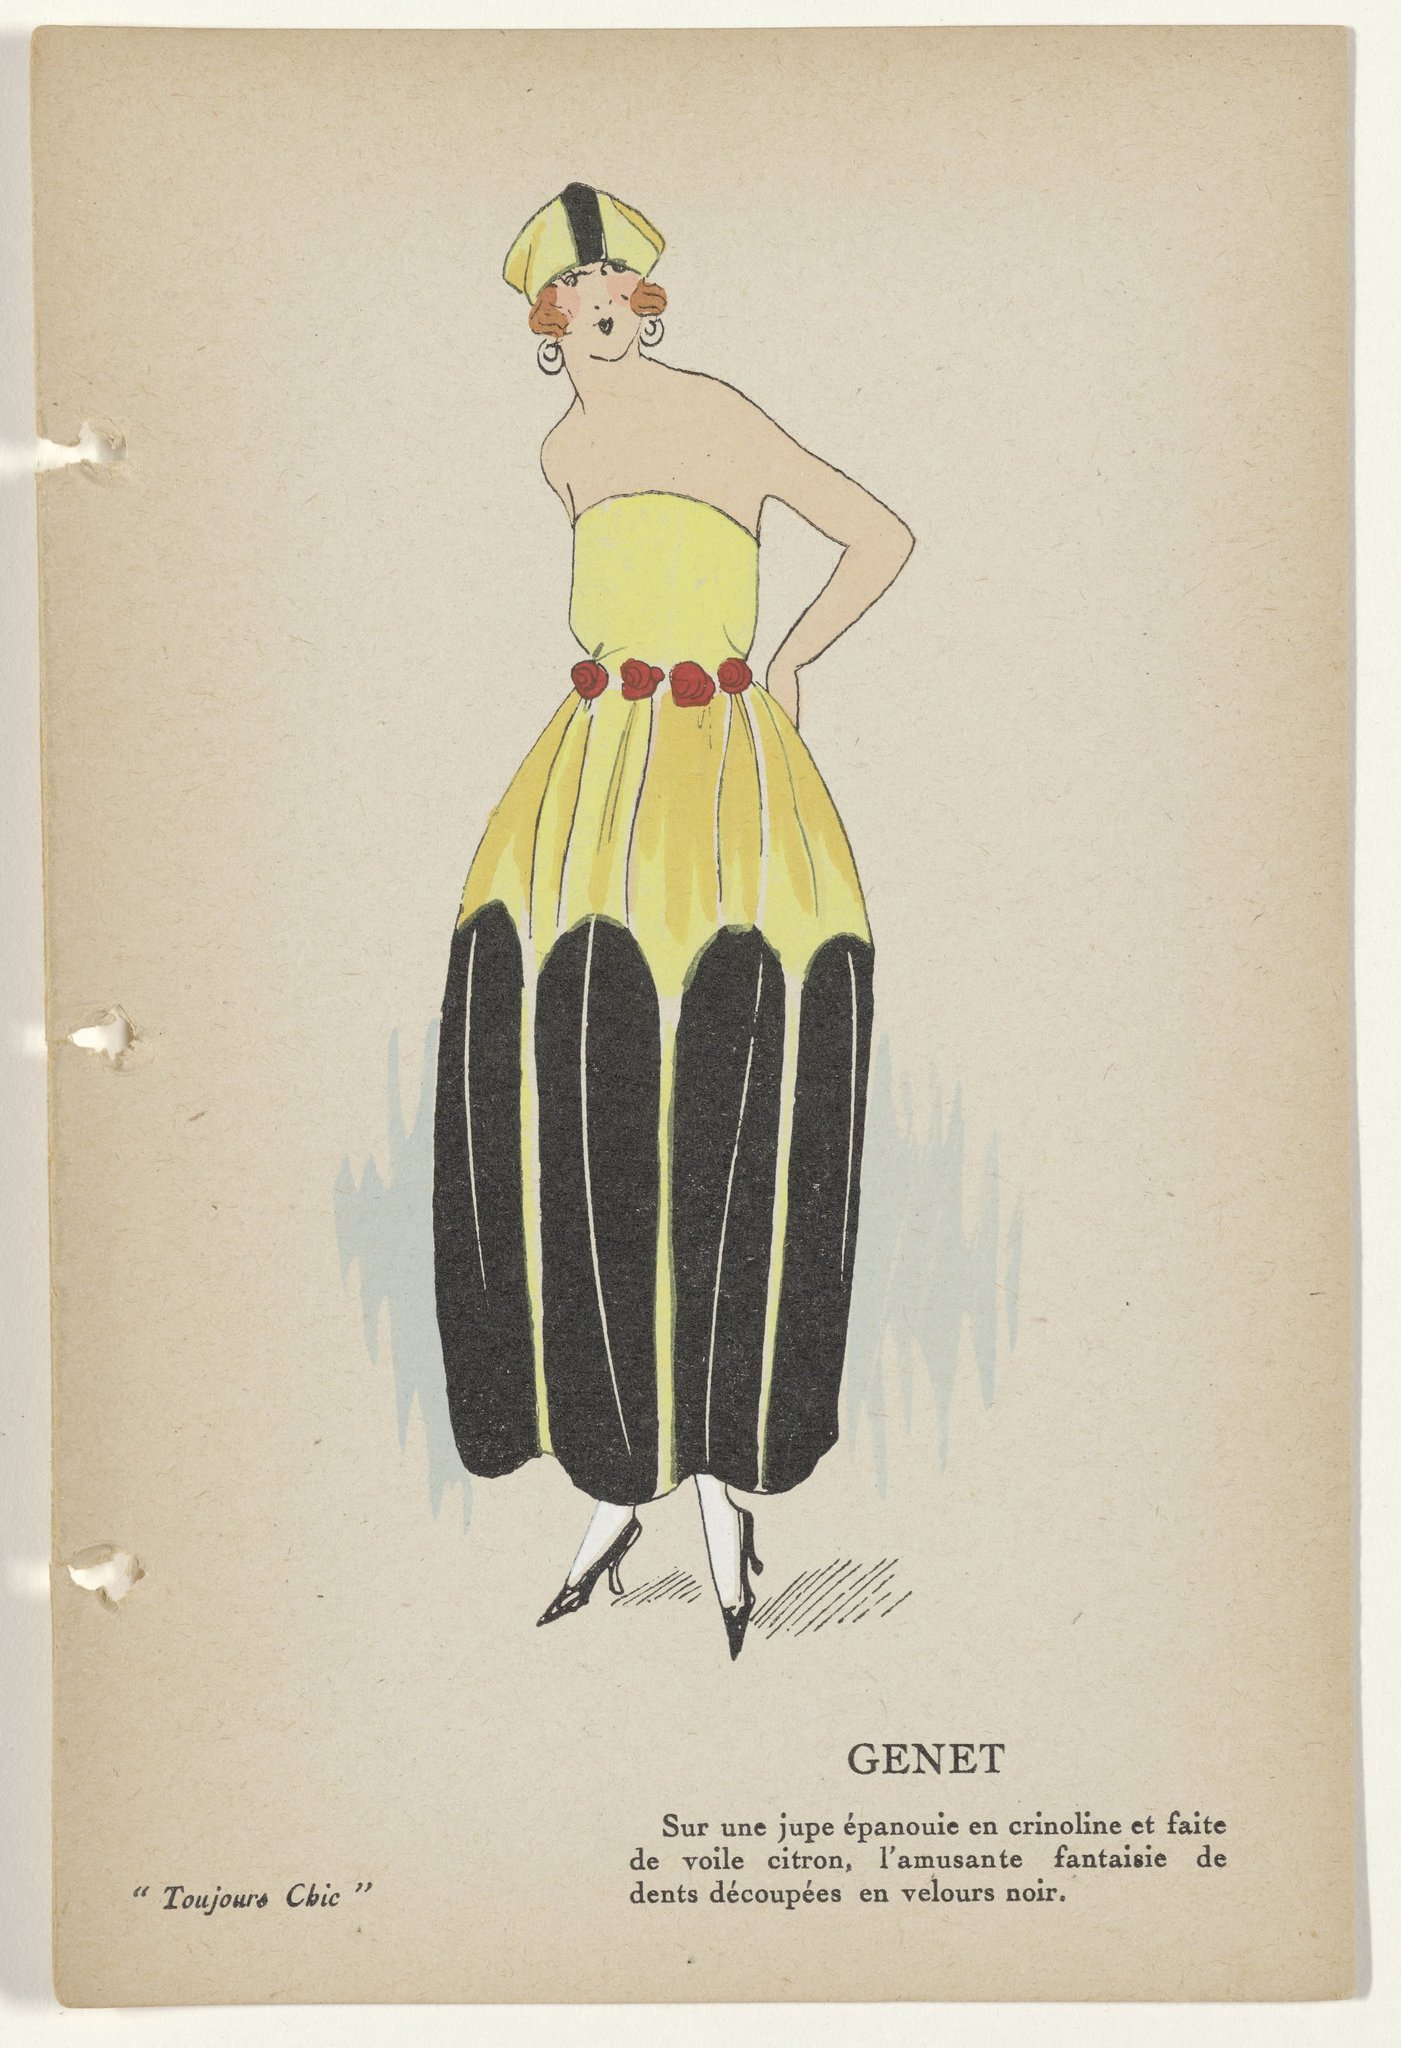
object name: titelprent, frontispice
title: Toujours Chic, Toilettes de Soirées, Hiver 1921-1922: Genet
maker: g-p. joumard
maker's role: publisher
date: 1921-1922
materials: paper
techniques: letterpress printing, pochoir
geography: paris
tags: fashion plates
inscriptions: date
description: Prent uit Catalogus "Toujours Chic" waarin een overzicht van de wintermode 1921-1922 in 80 prentjes in pochoir techniek.